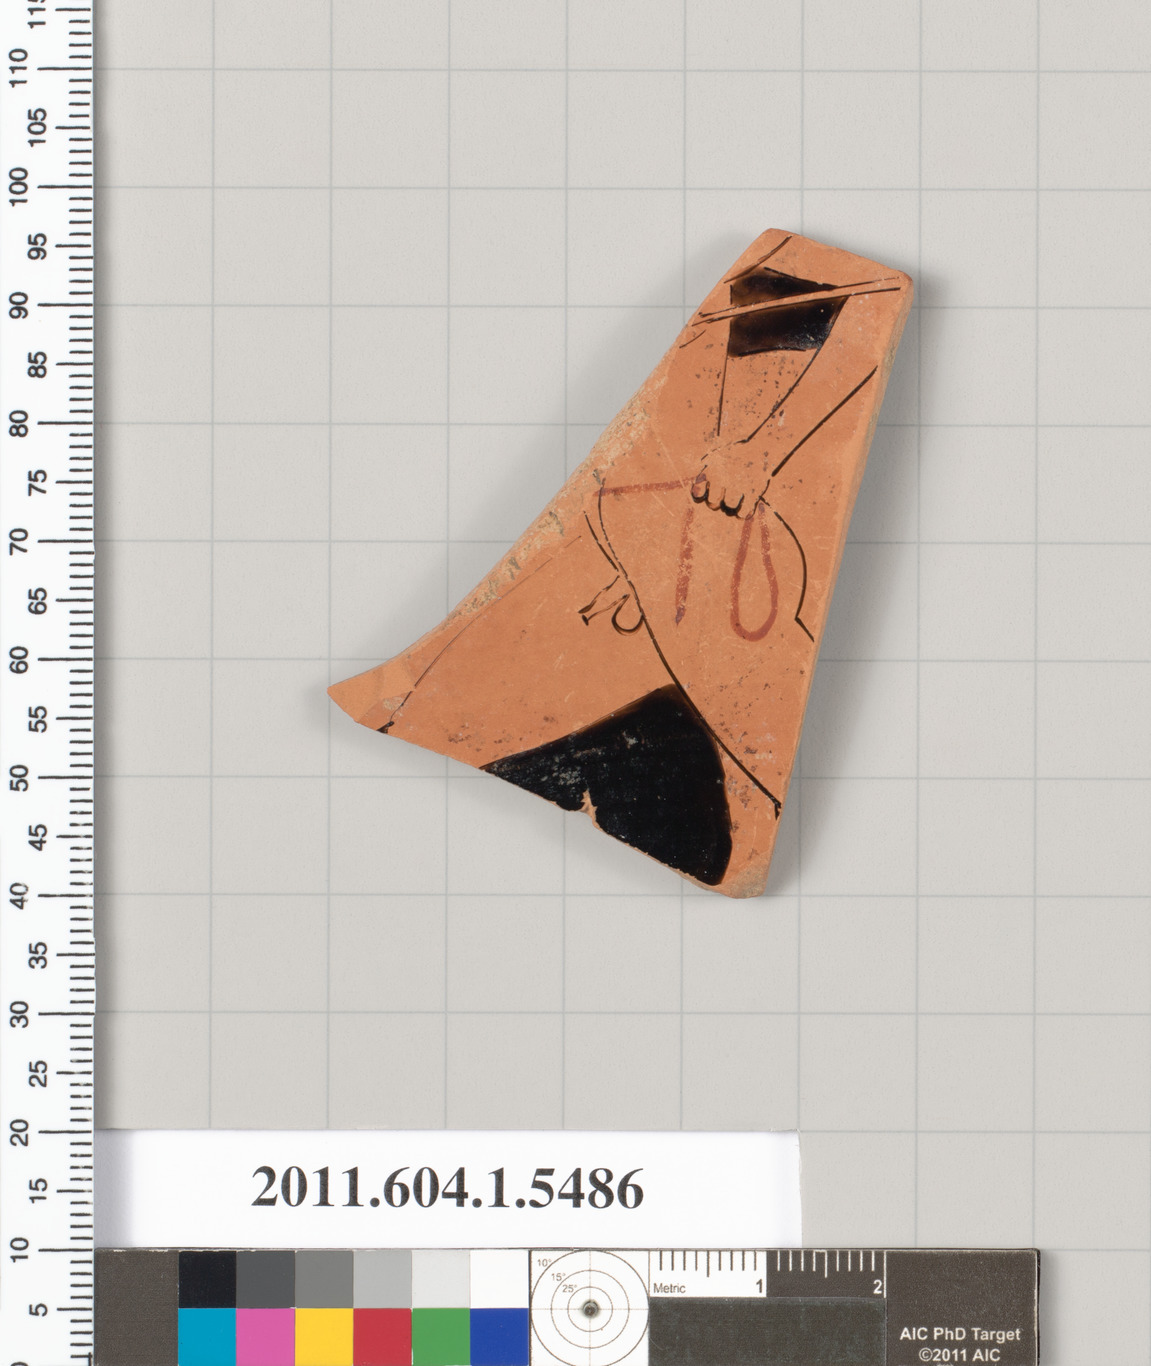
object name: kylix fragment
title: Terracotta fragment of a kylix (drinking cup)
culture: greek, attic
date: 500-480 BCE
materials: terracotta